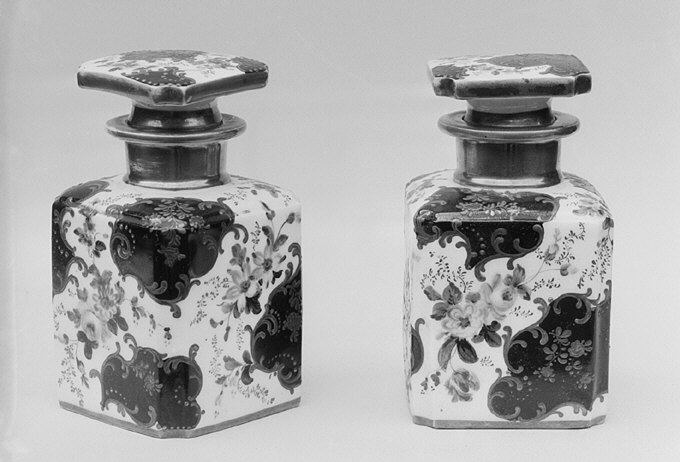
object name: perfume bottle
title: Pair of perfume bottles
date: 1801-1900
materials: hard paste porcelain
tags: flowers